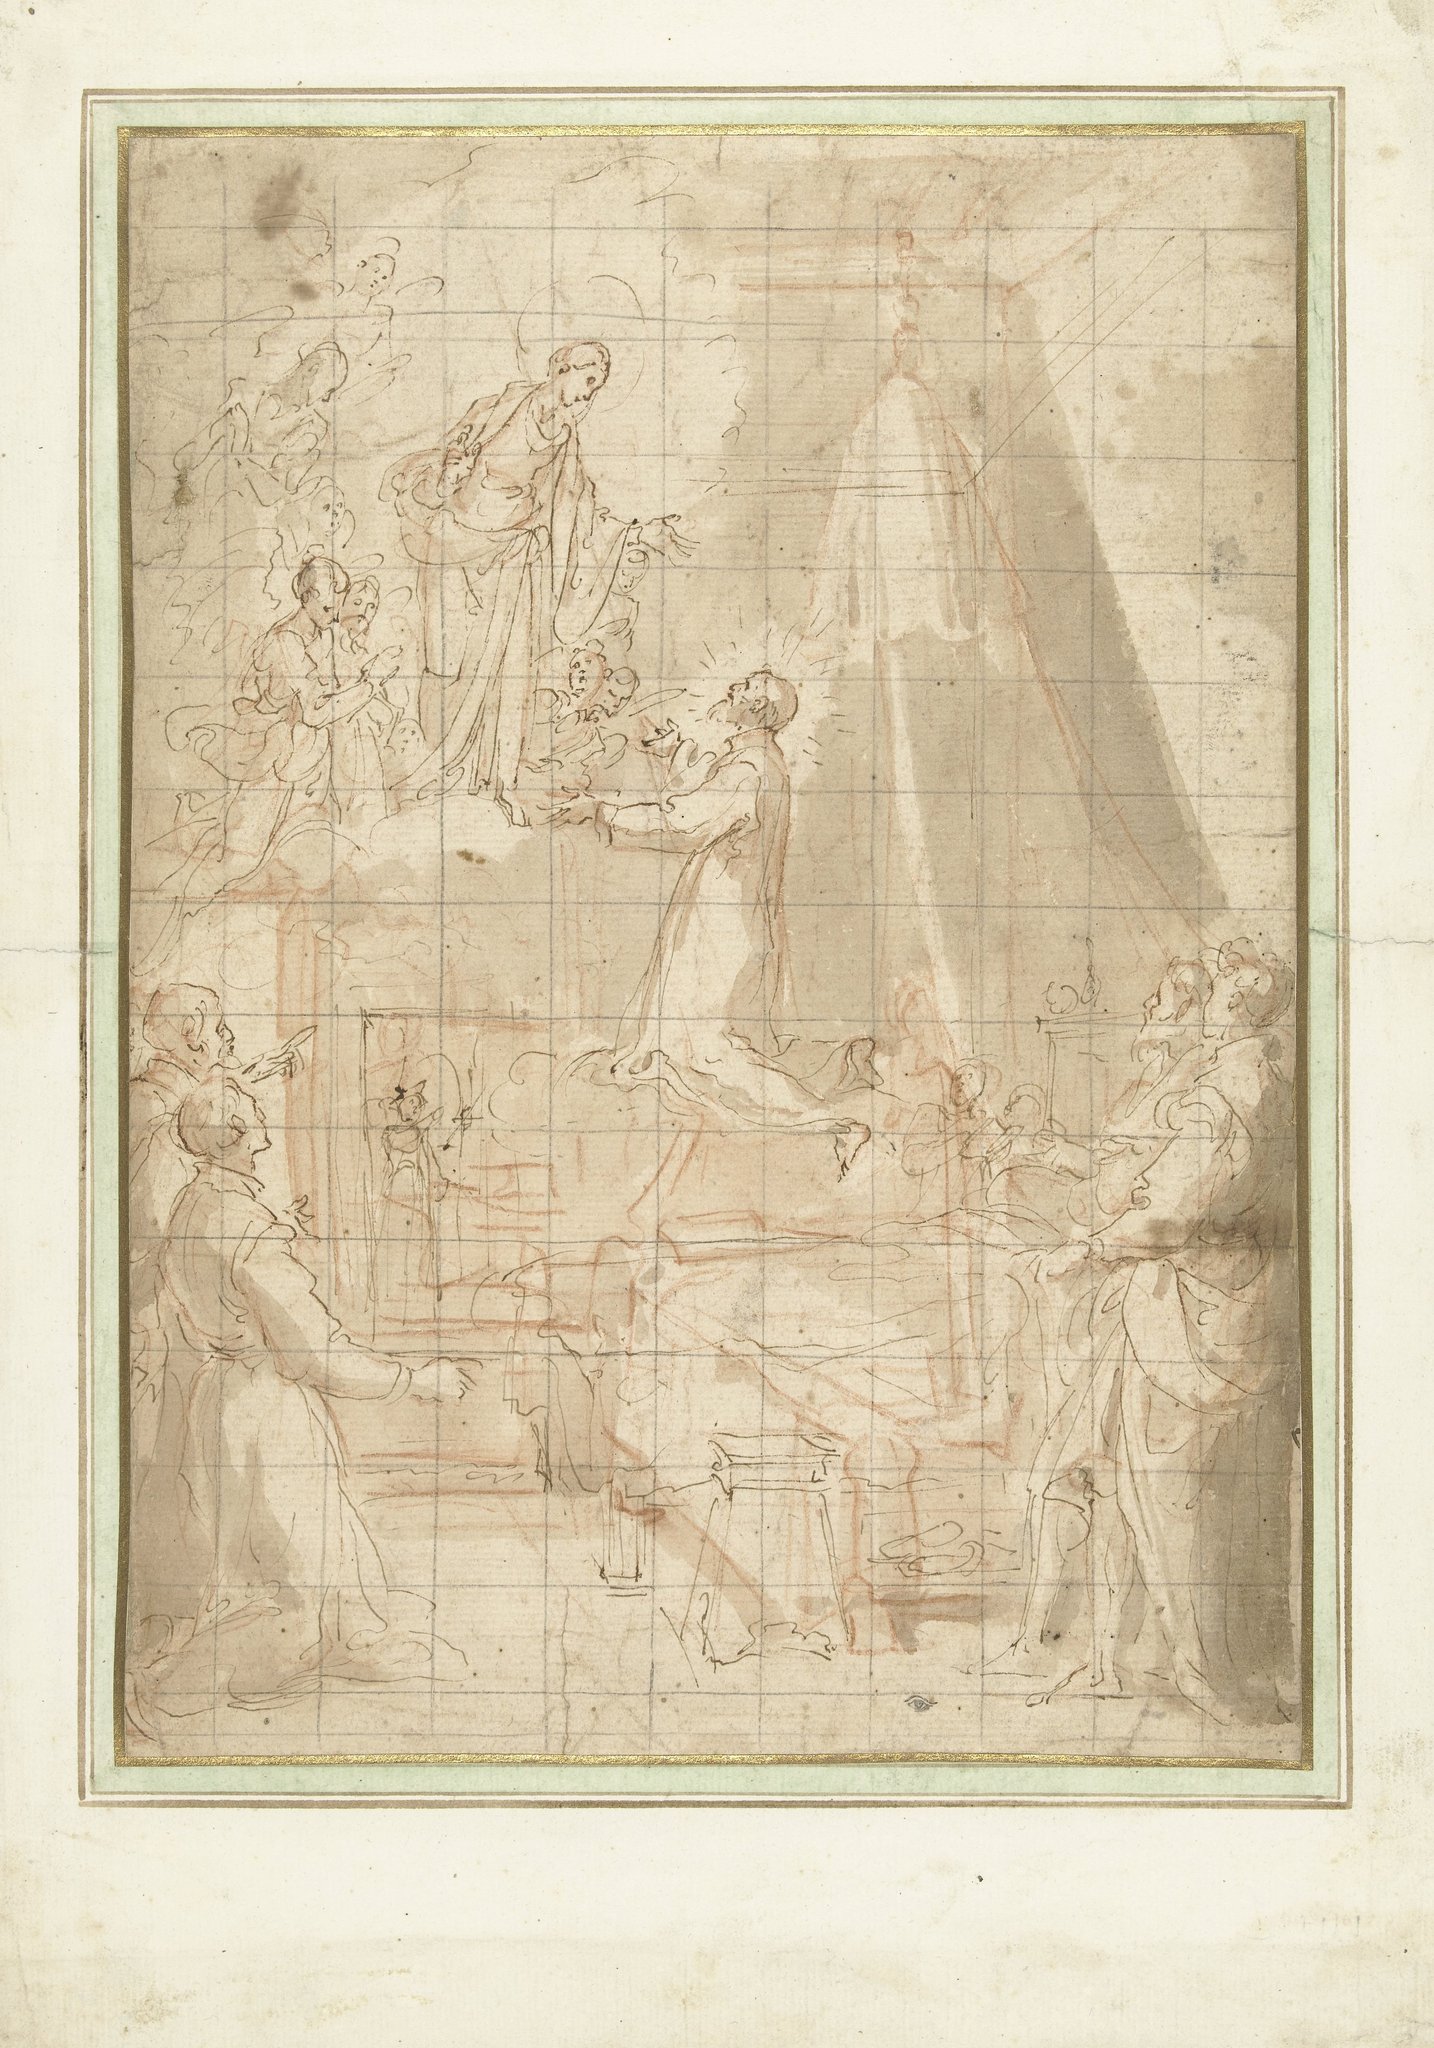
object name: drawing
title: Maagd Maria verschijnt aan de heilige Filippo Neri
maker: bernardino poccetti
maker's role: draughtsman, painter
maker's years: 1545-1612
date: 1558-1612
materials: chalk, ink, paper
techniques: brush, pen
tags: the founder of the congregation of the oratory (oratorians) philip neri; possible attributes: lily, rosary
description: De Maagd Maria verschijnt aan de heilige Filippo Neri, op zijn ziekbed.